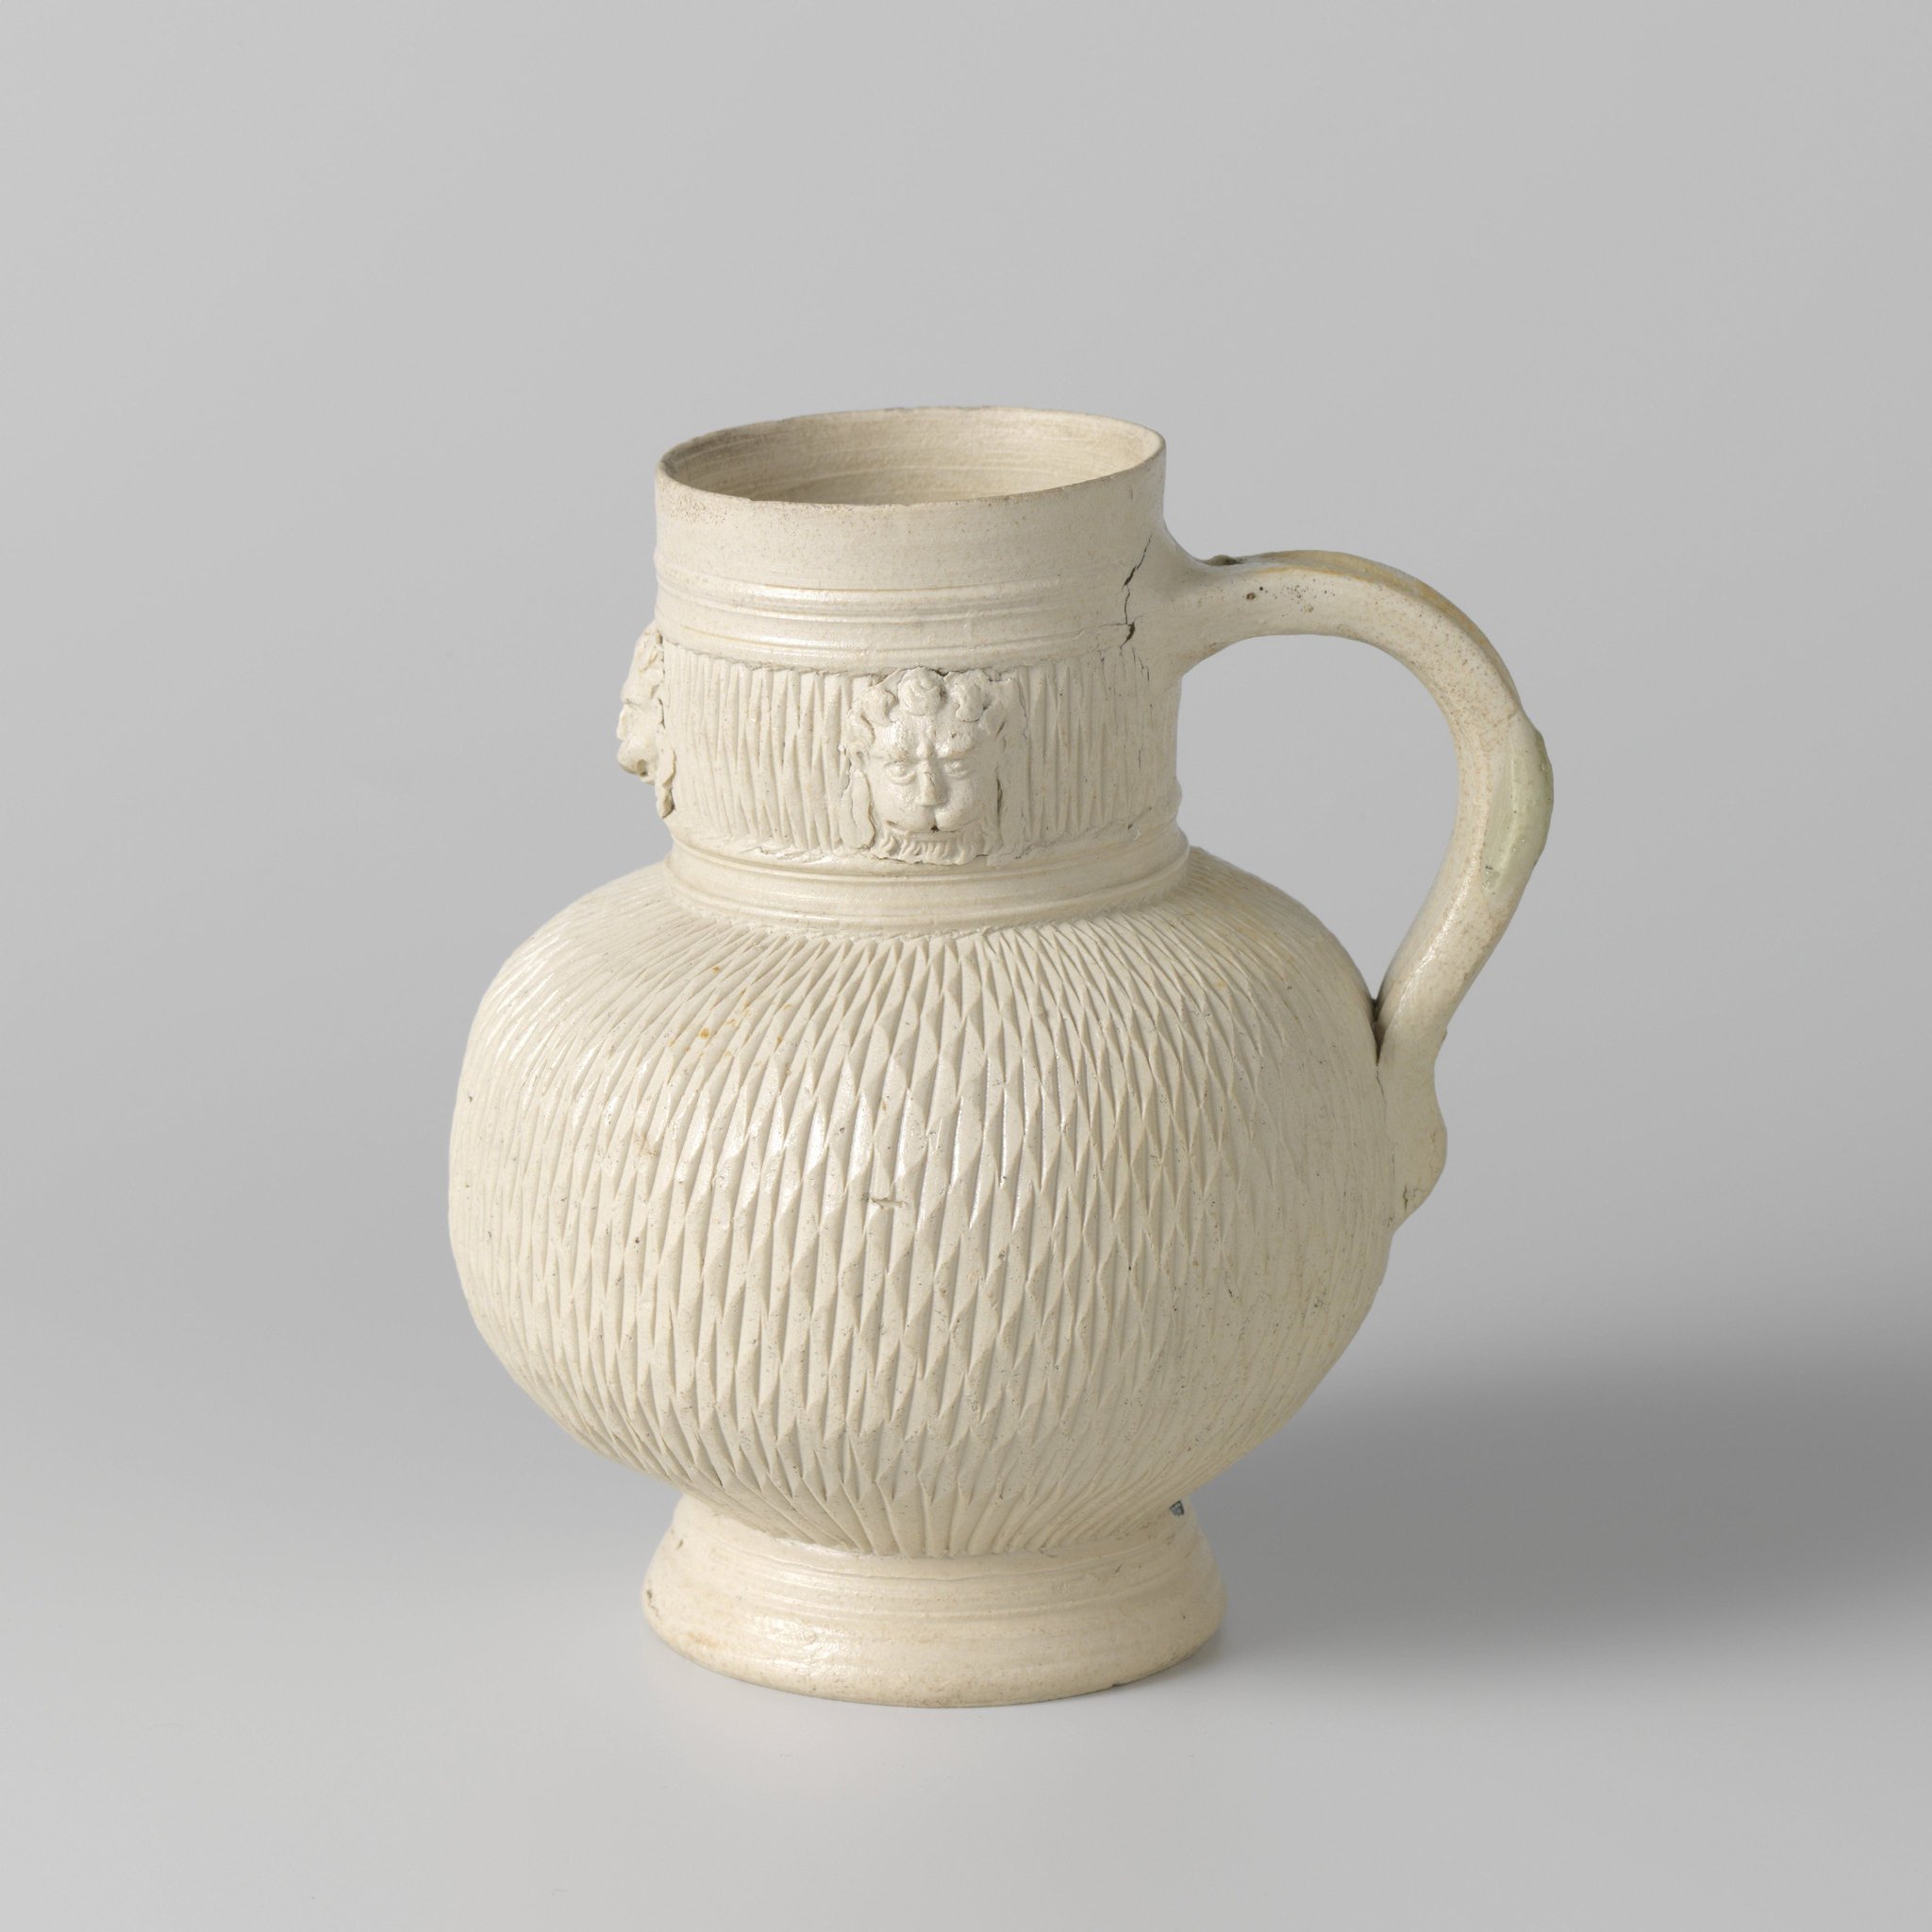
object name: jug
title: Jug with chip carving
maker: Anonymous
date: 1580-1600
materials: glaze, stoneware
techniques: firing, forming, relief, turning, vitrification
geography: siegburg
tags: lion's head ~ ornament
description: Kruik van steengoed op hoge voet met een bolvormig lichaam en wijde nek. Het C-vormige oor is bevestigd aan de nek en de buik. Profielen op de nek en de voet. Zowel de buik als de nek zijn versierd met kerfsnede, met daarbij op de nek driemaal een gedrukte en opgelegde leeuwenkop in reliëf. Siegburg.